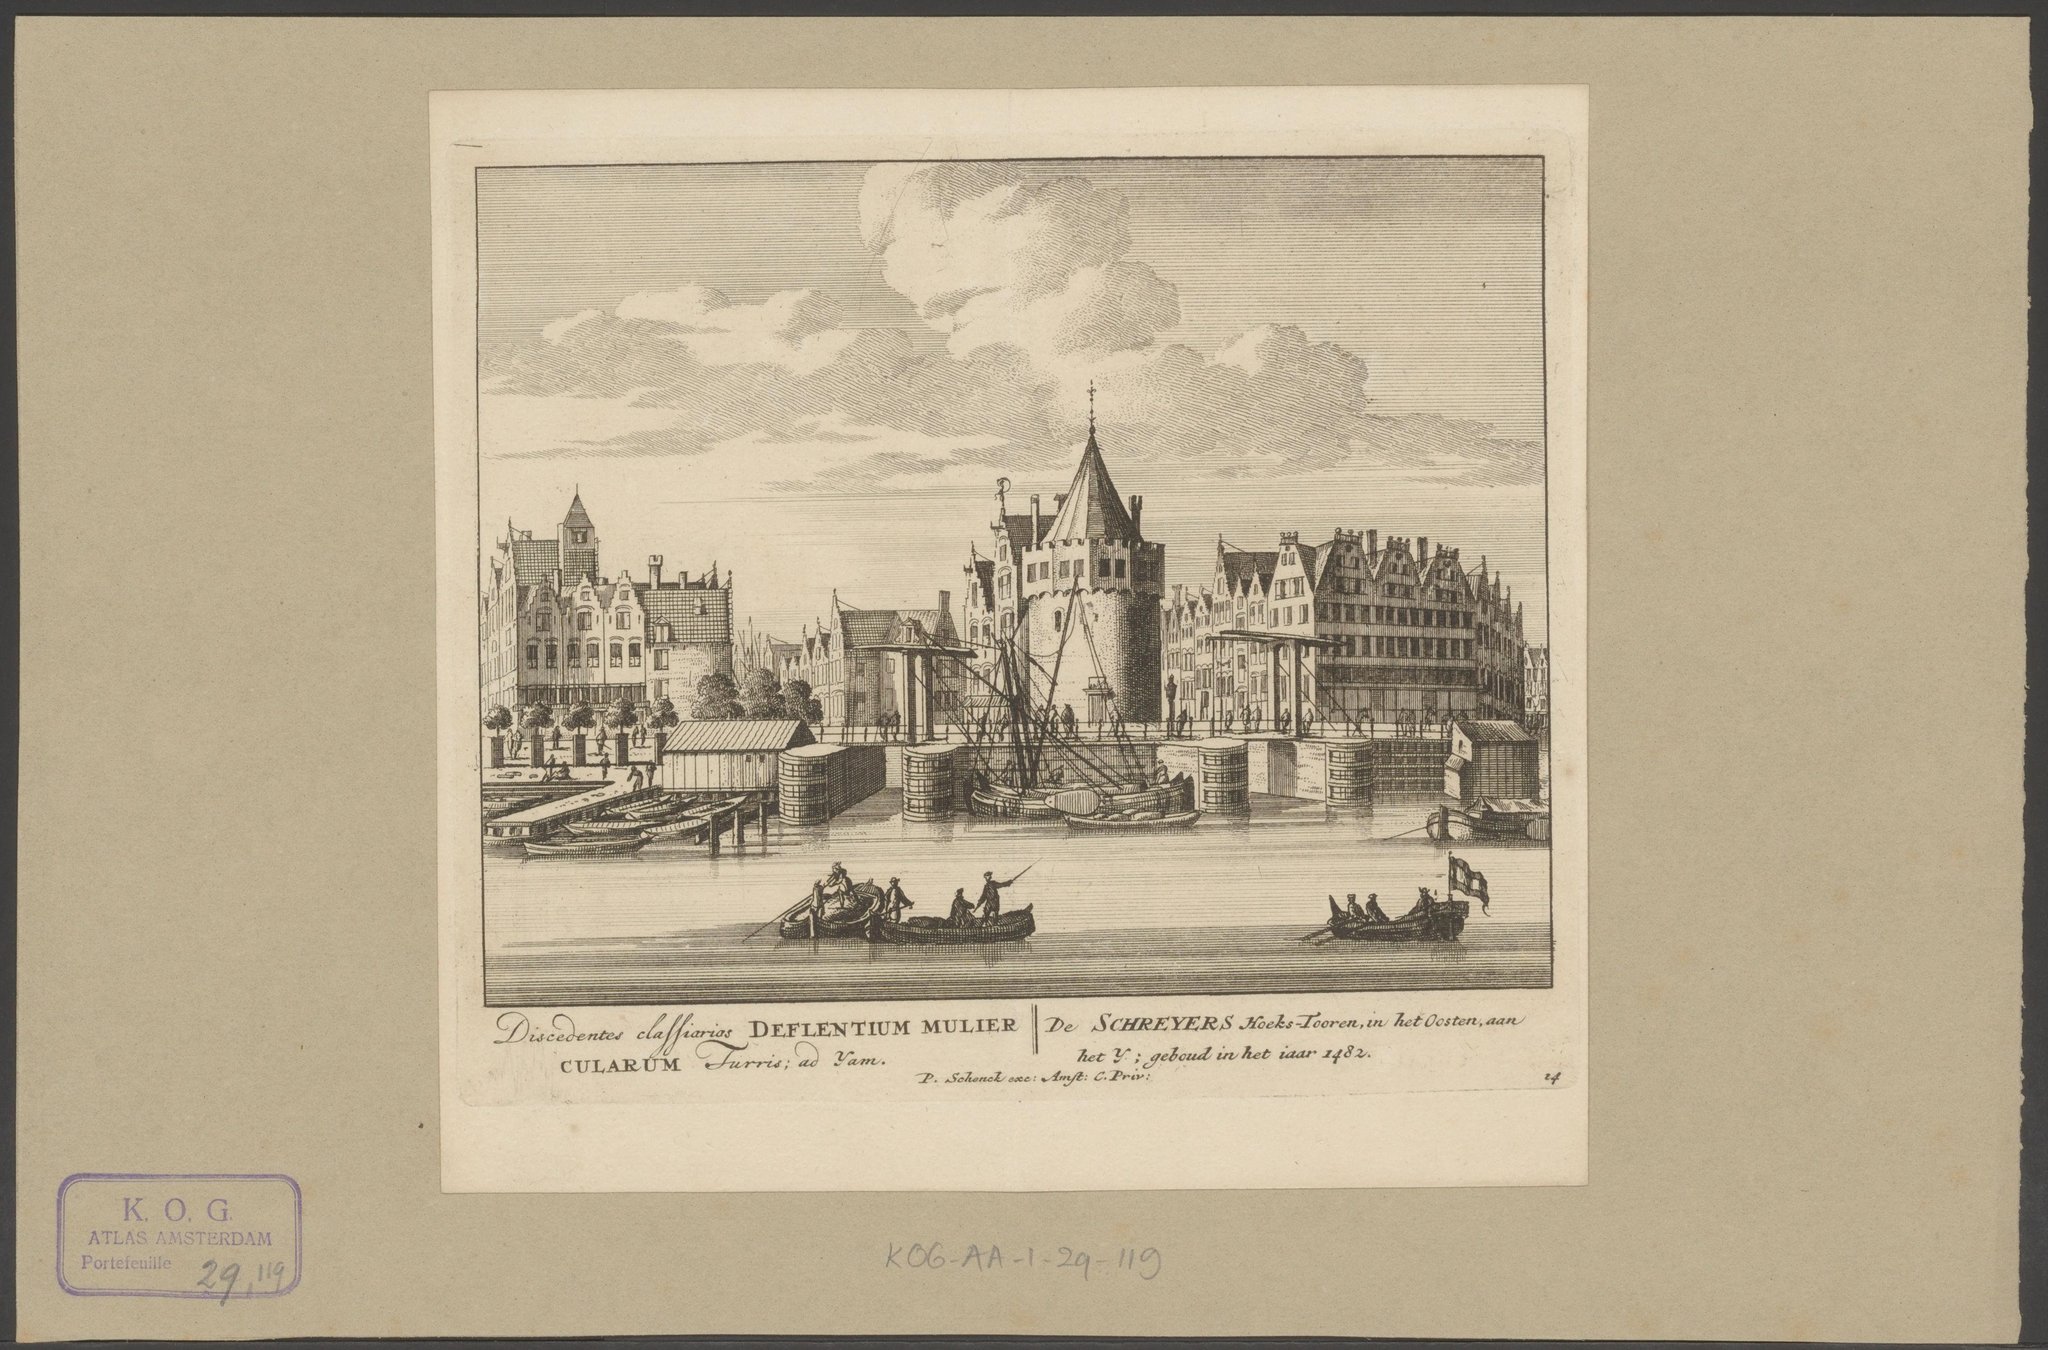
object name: print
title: Gezicht op de Schreierstoren te Amsterdam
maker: Anonymous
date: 1710-1711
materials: paper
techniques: engraving, etching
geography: northern netherlands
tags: bridge in city across river, canal, etc. (+ city(-scape) with figures, staffage), towers ~ fortified city, rowing-boat, canoe, etc.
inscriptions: collector's mark: Lugt 1641b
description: Prent mogelijk uit: 100 Afbeeldinge der voornaamste gebouwen van Amsterdam. Amsterdam: Pieter Schenk (I), s.a. [1710-1711]. Of uit: 100 Afbeeldinge der voornaamste gebouwen van Amsterdam. Amsterdam: Barent Greve, s.a. [1757-1766]. In de tweede uitgave, uitgegeven door Barent Greve, is alleen de titelprent aangepast. De overige prenten zijn onveranderd gebleven.